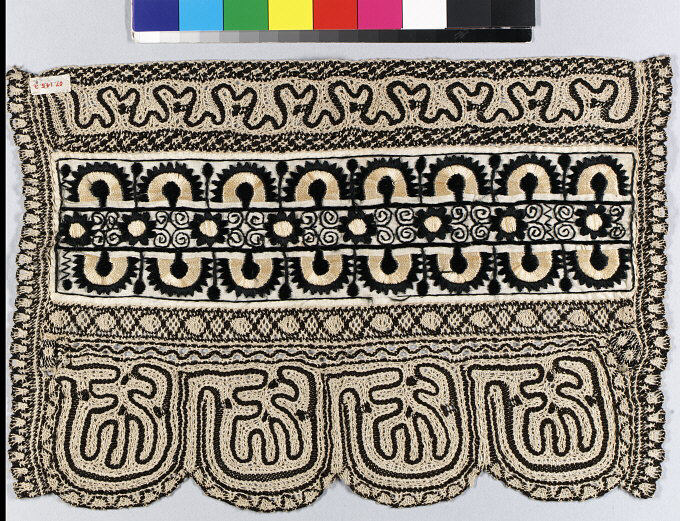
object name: cuff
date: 1801-1900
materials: linen, silk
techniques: lace